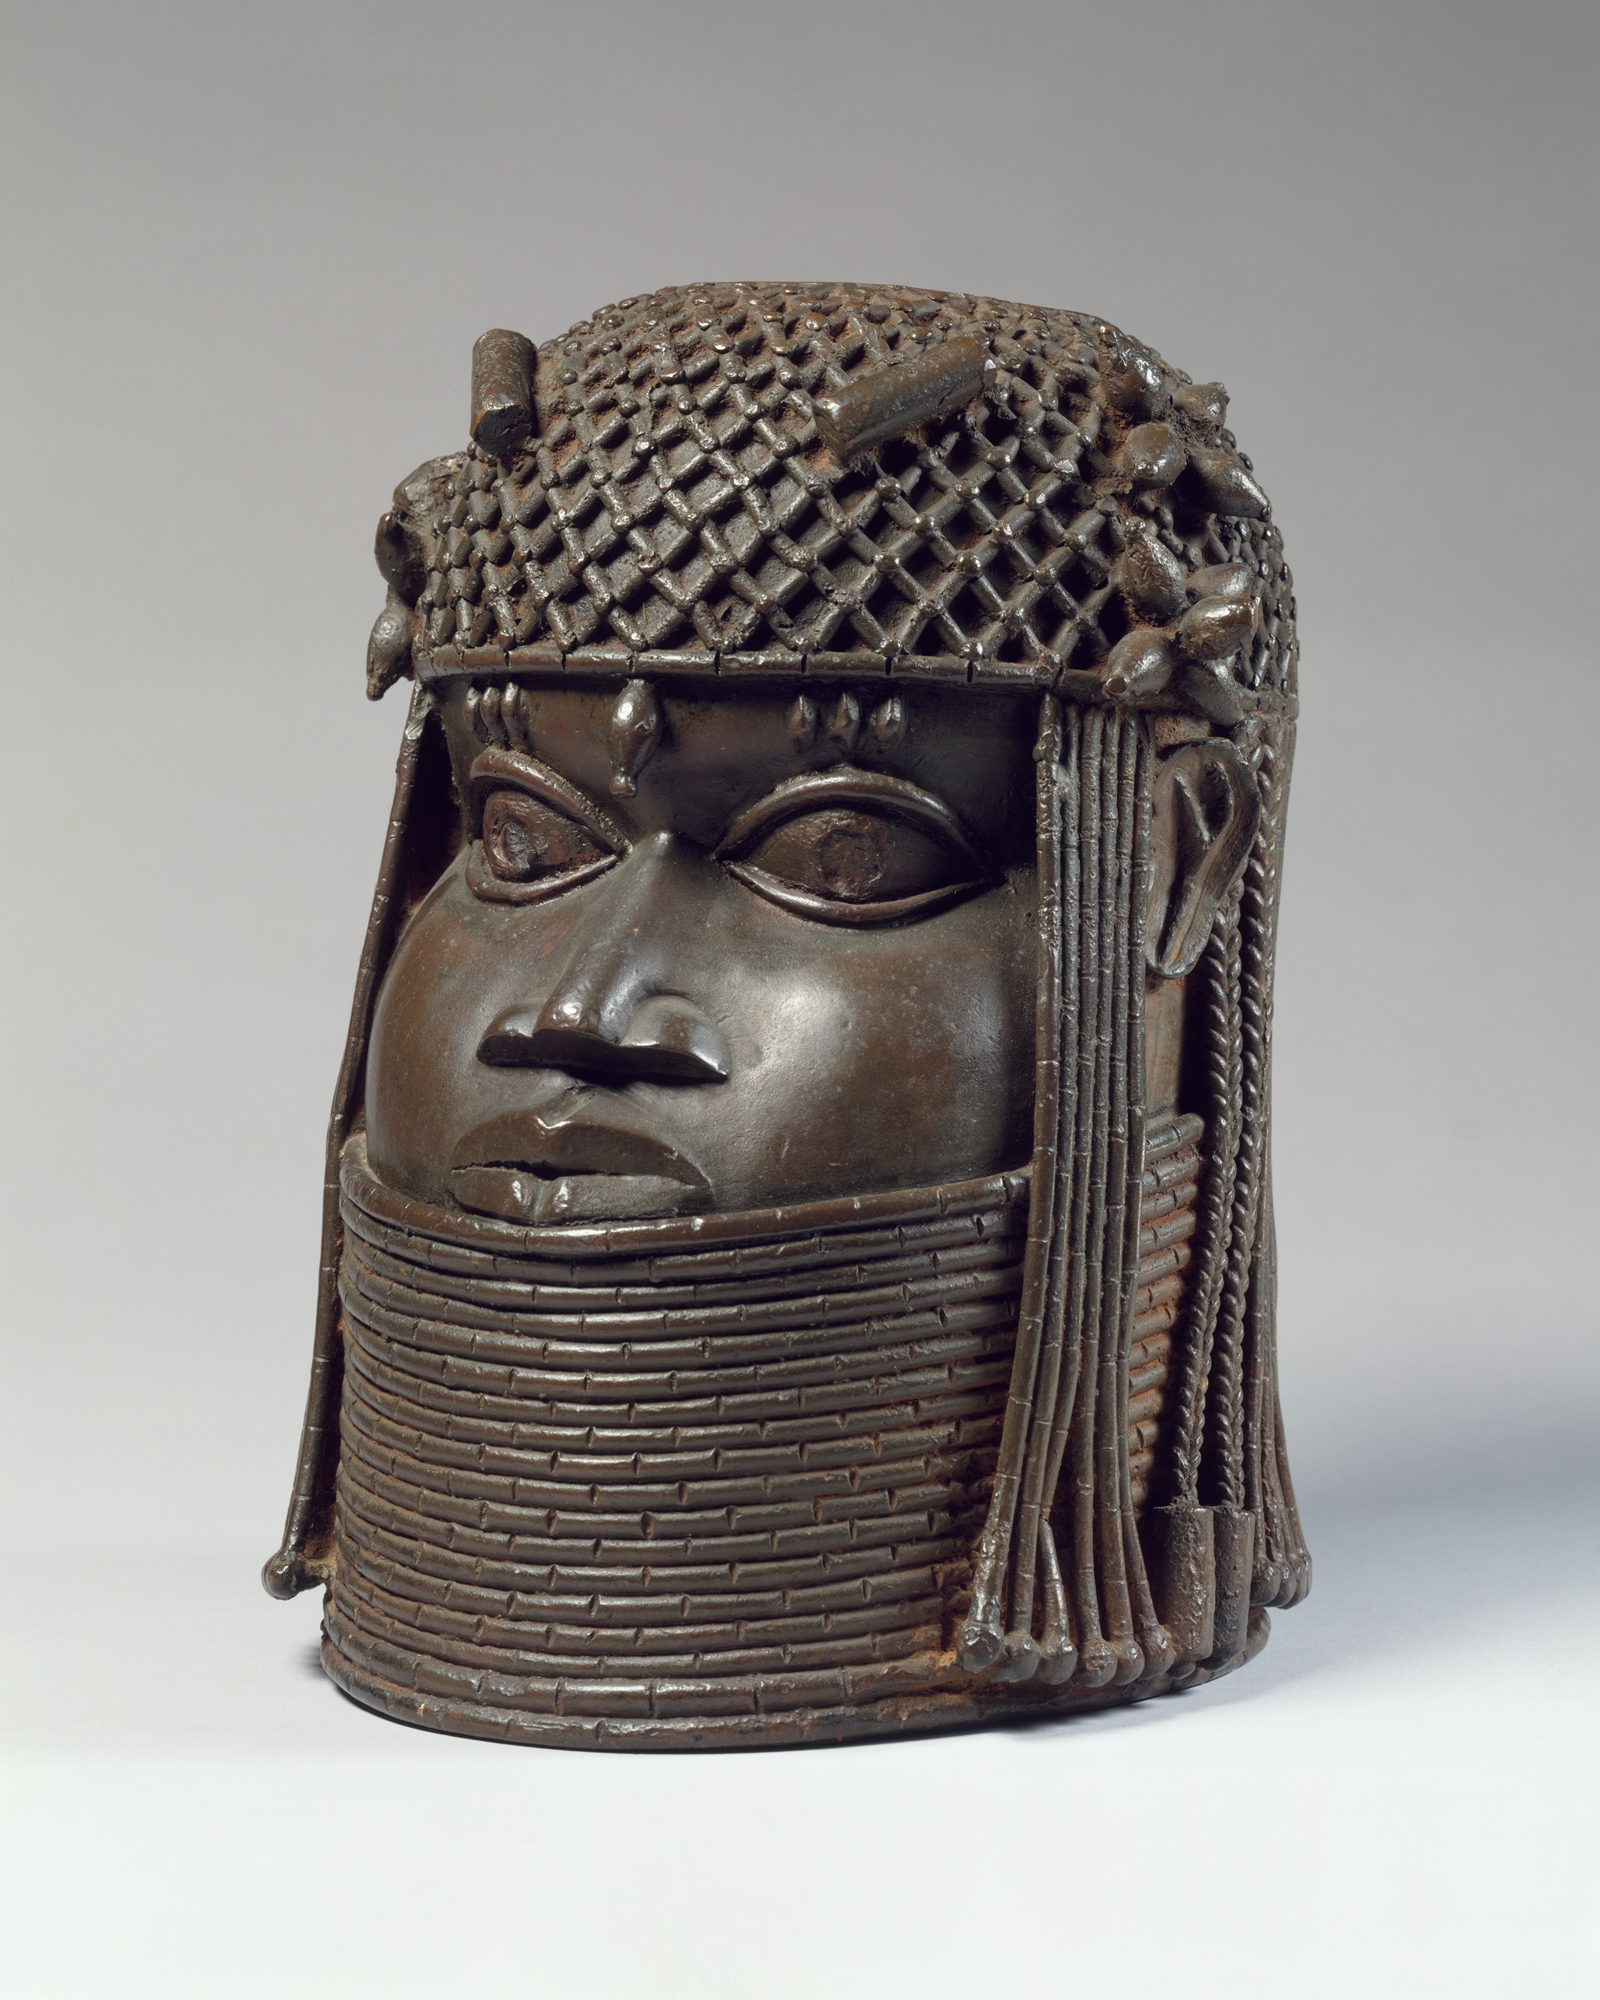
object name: head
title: Ùhúnmwèlaò (head of an ọ́bà)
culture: edo period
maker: ìgùn ẹ́rọ̀nwwọ̀n (brass-casting guild) artists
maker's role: artist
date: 1534-1700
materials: brass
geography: nigeria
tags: heads